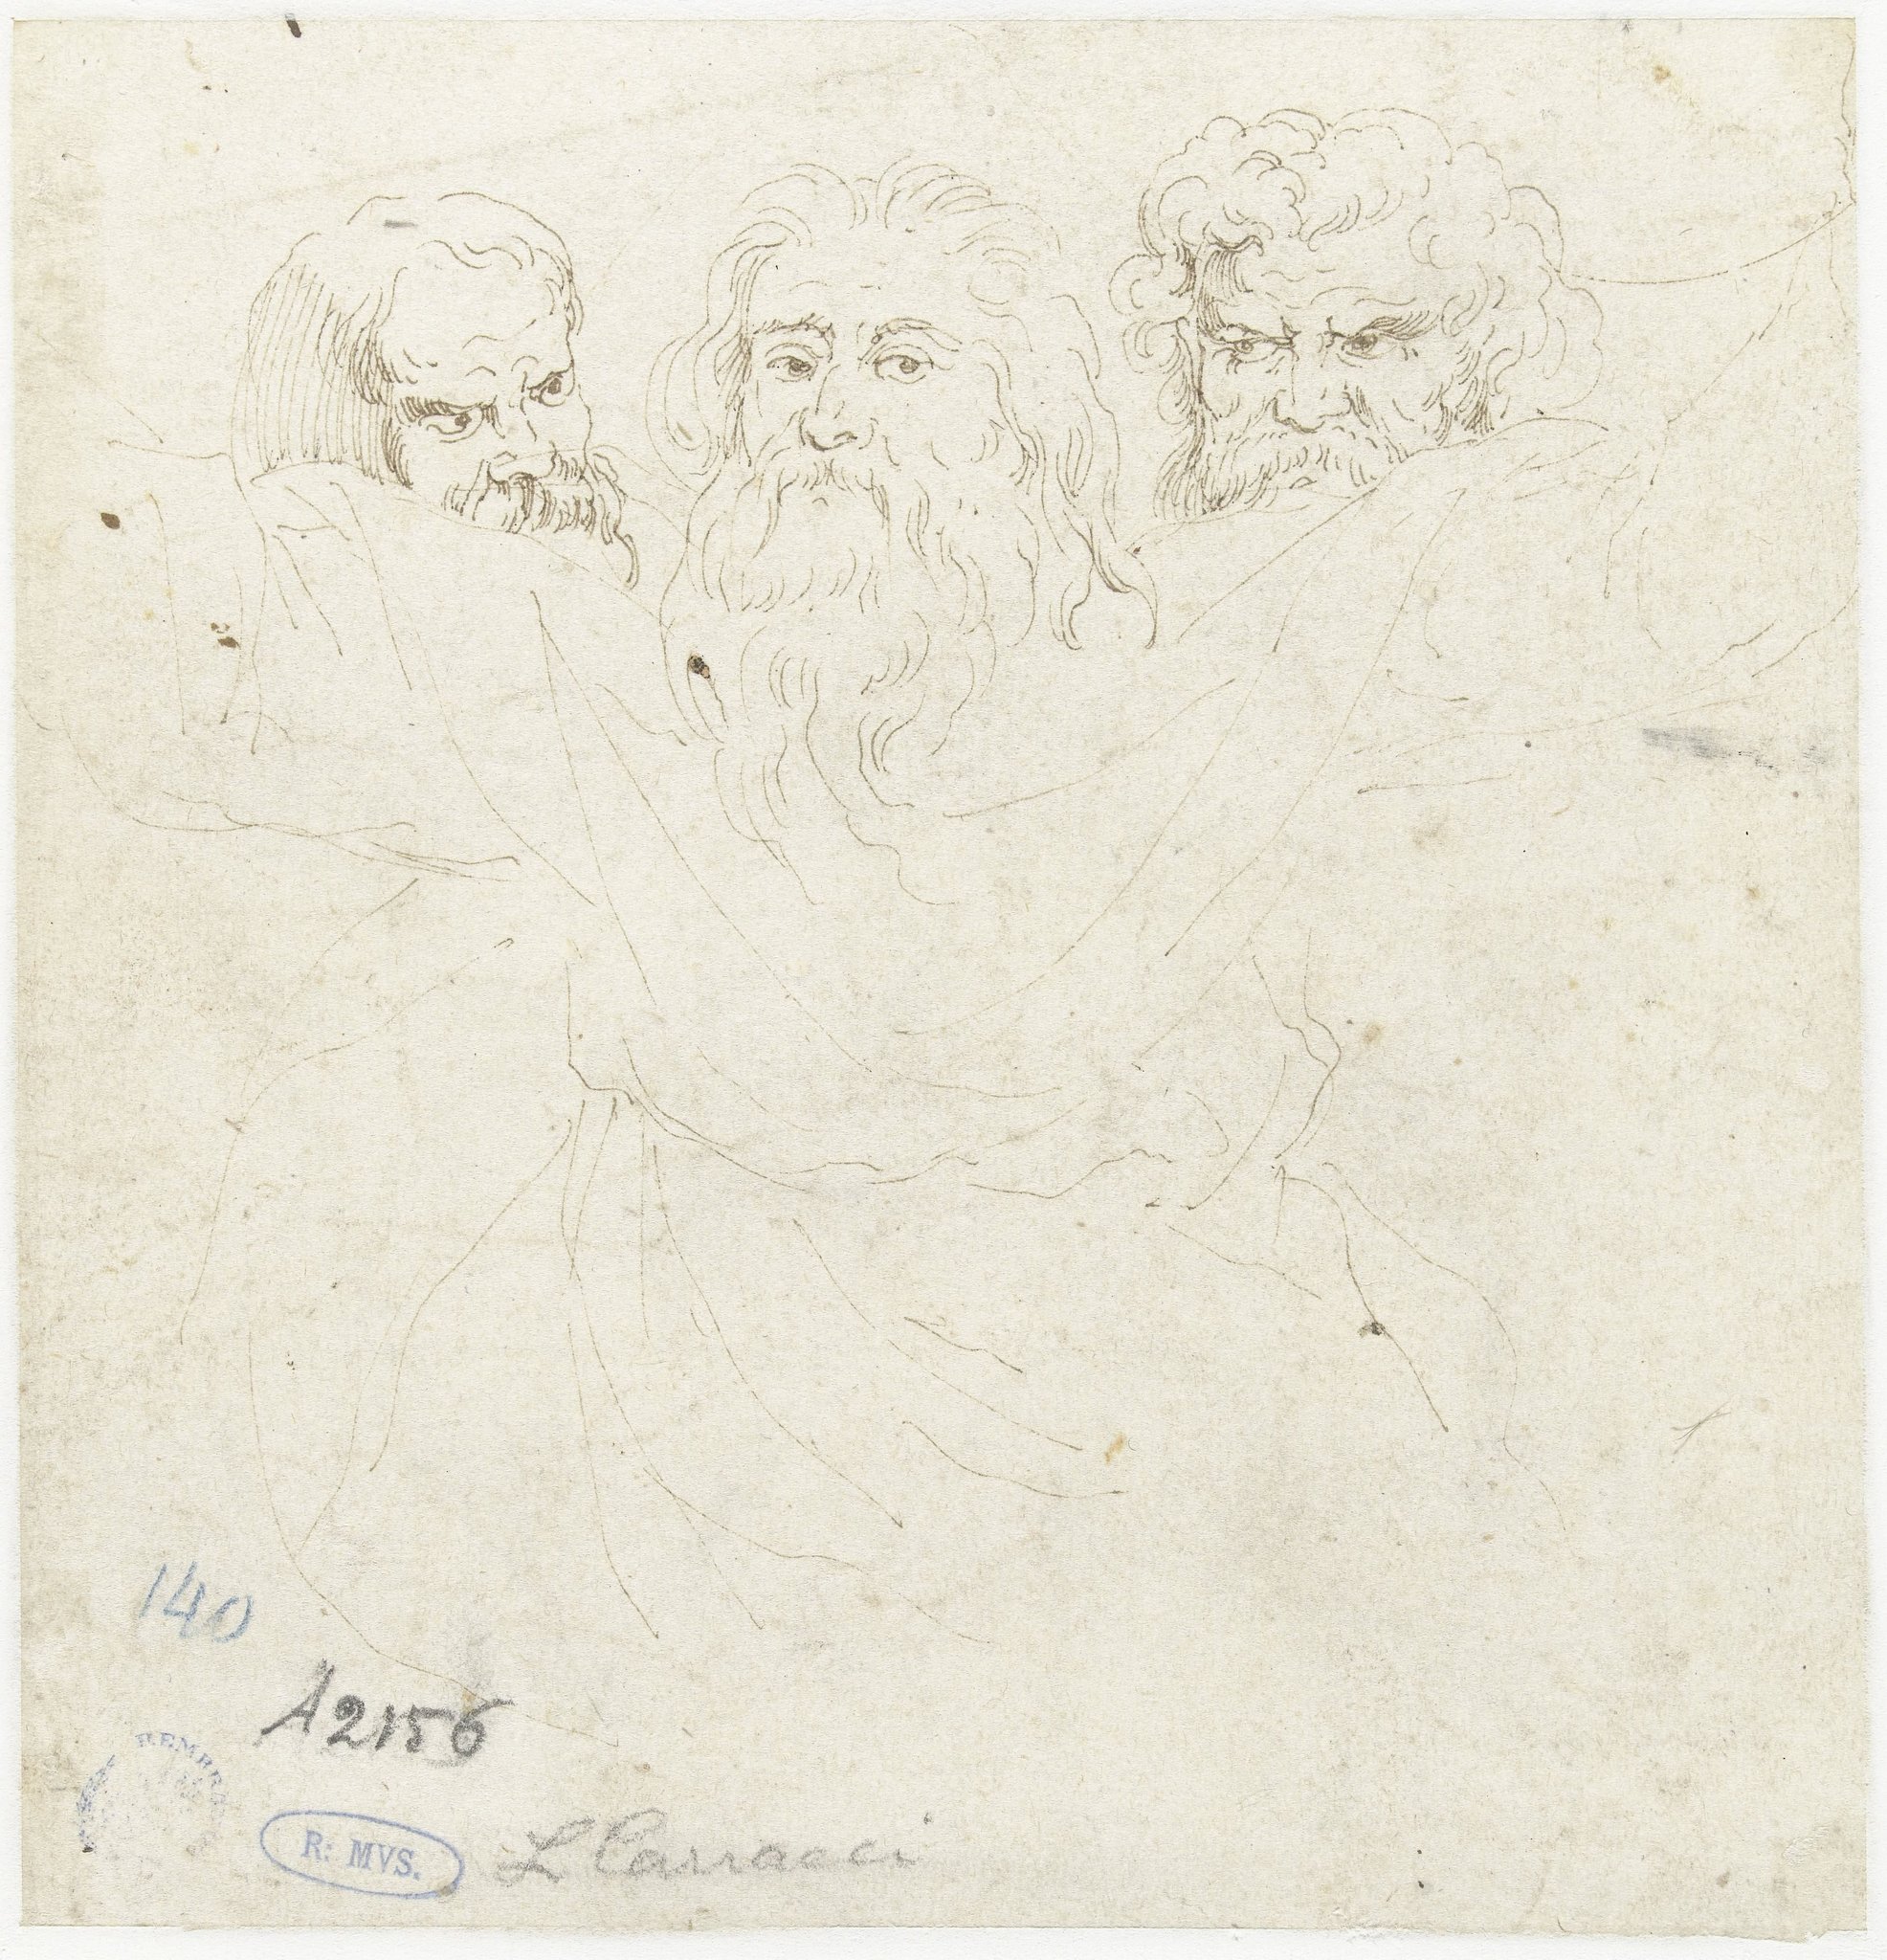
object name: drawing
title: Hoofden van drie oudere mannen met baarden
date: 1610-1641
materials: ink, paper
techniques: pen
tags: head (human), old man